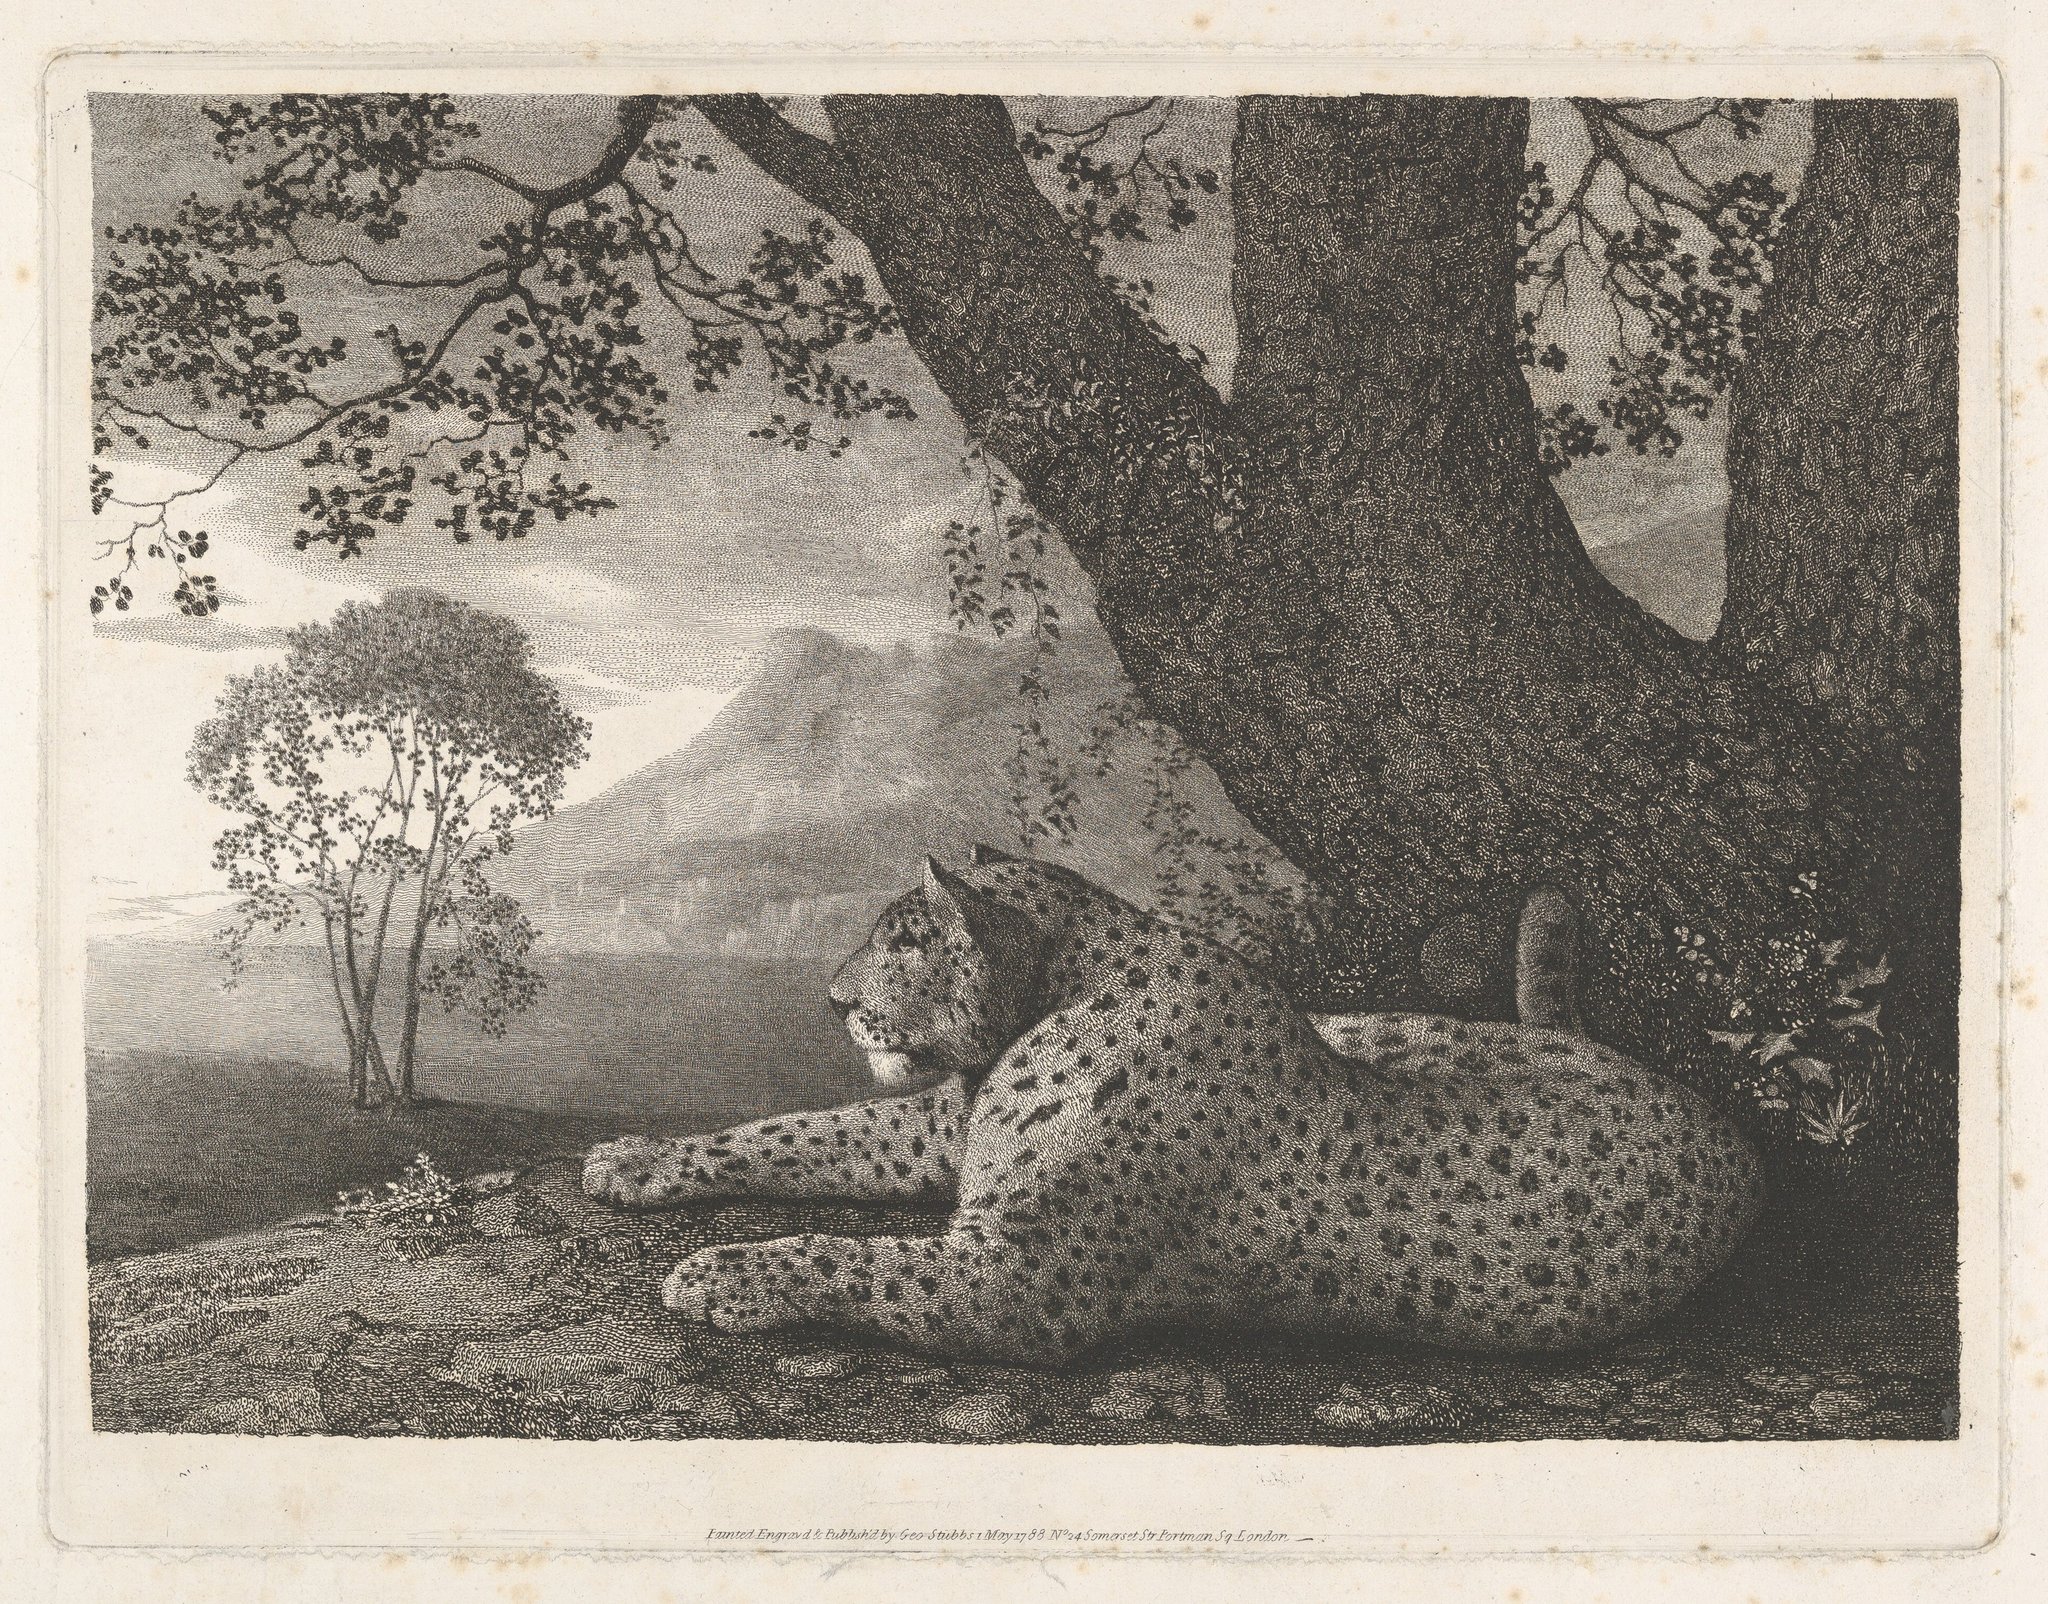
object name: print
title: A Tyger (A Recumbent Leopard by a Tree)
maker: george stubbs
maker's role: artist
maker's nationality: british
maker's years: 1724-1806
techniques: etching, roulette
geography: england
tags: leopards